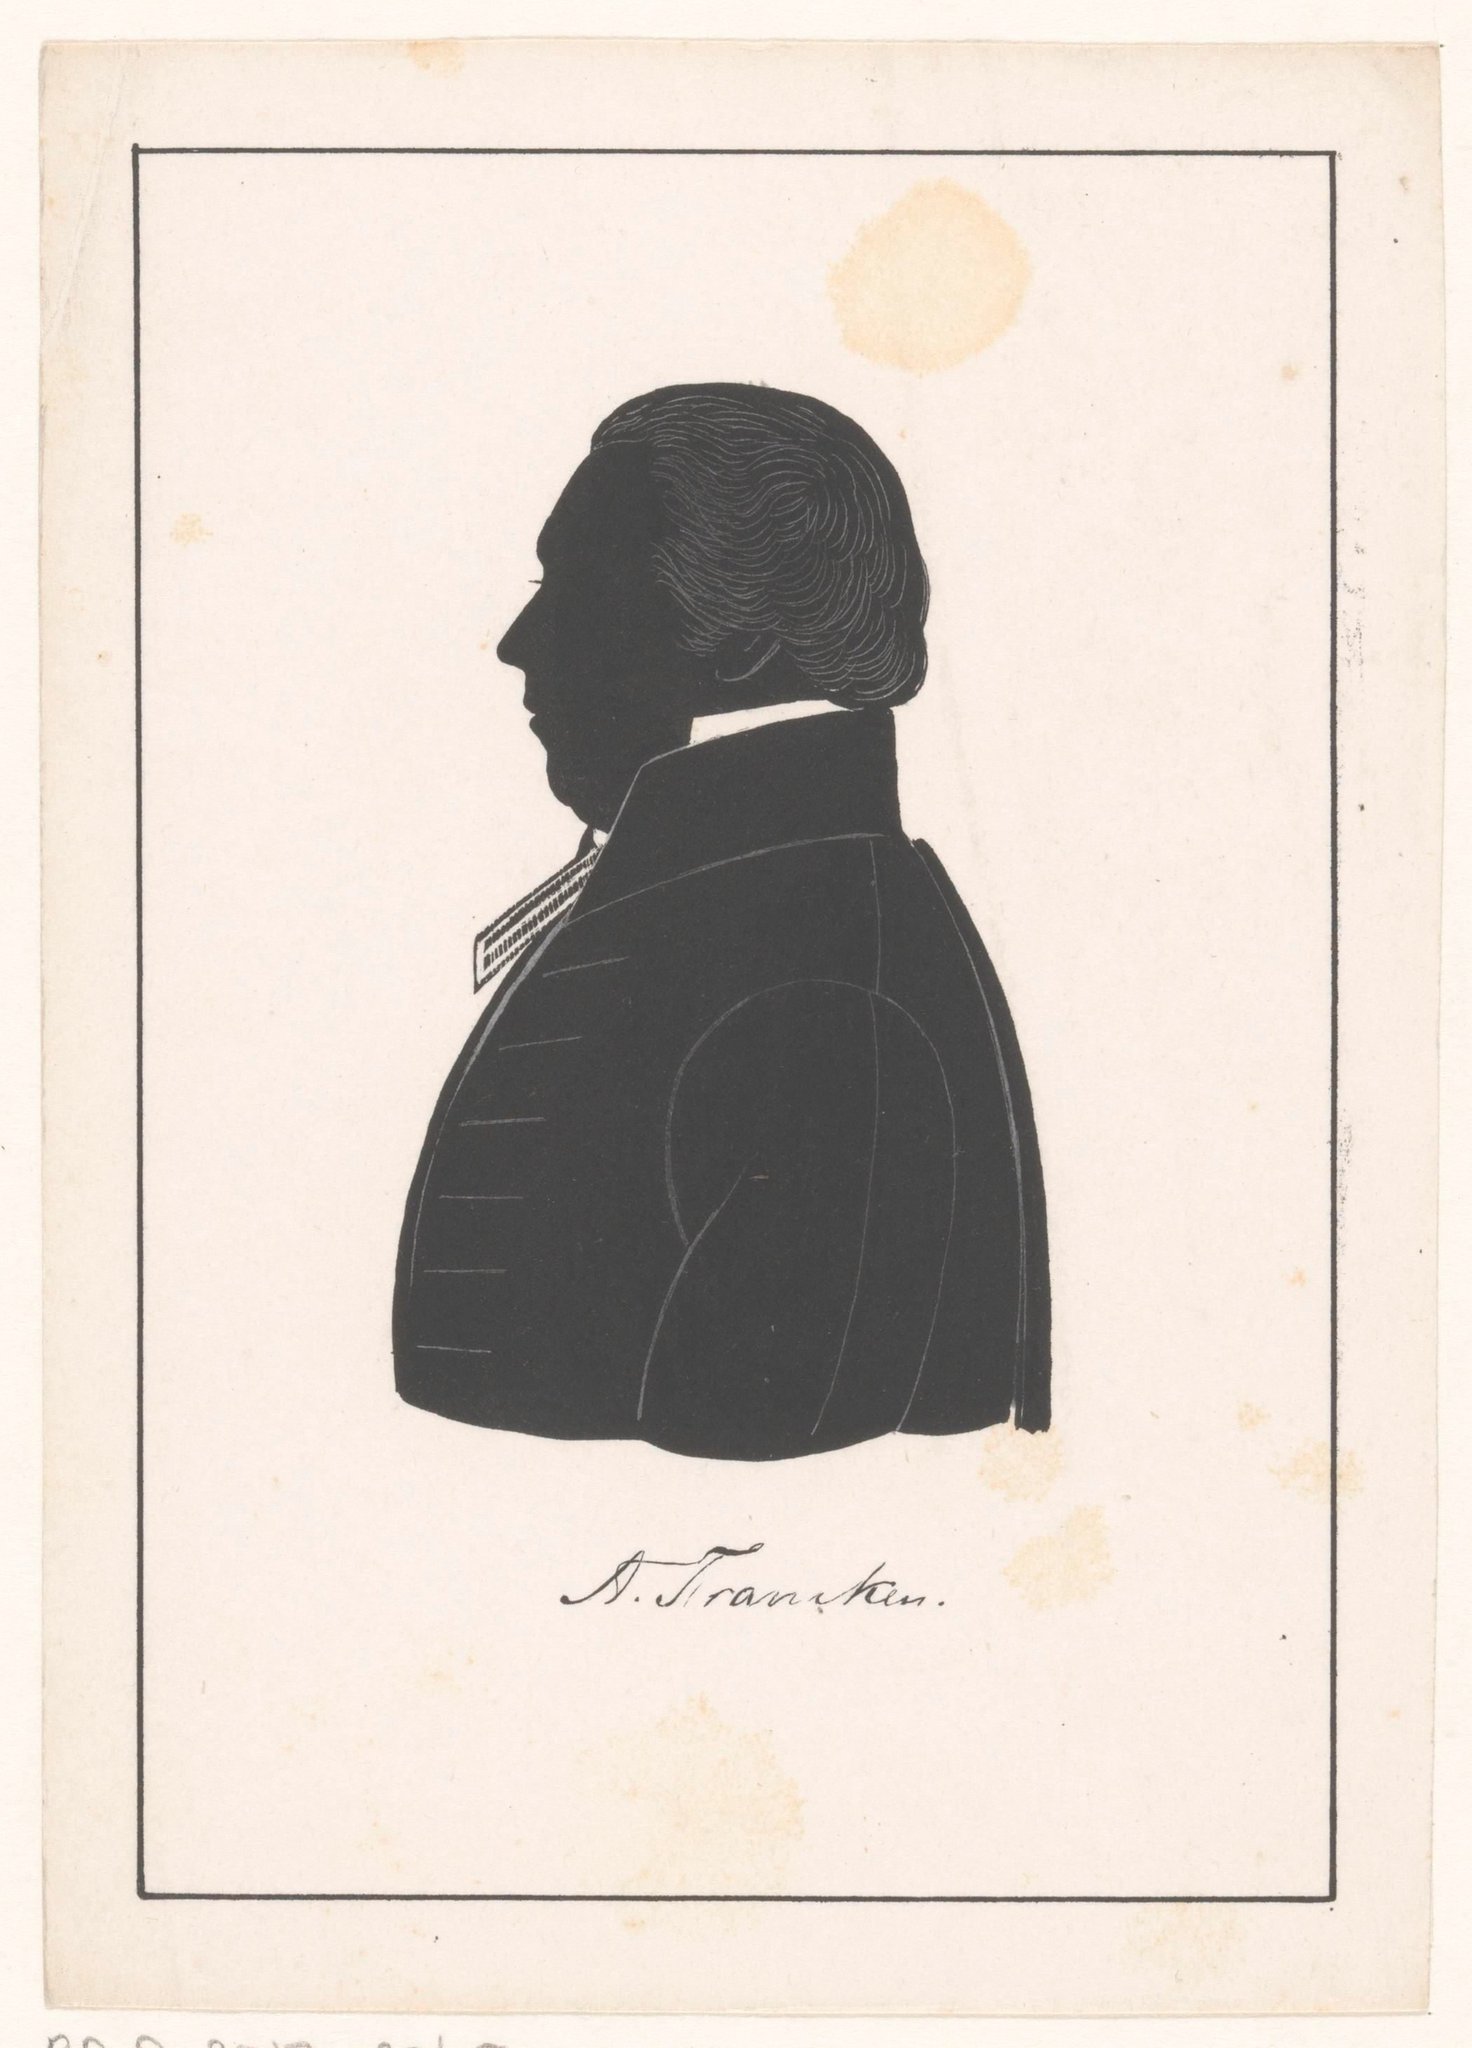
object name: print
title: Silhouetportret van Ahasueros Francken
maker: pieter barbiers (iv)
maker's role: painter, print maker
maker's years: 1798-1848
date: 1809-1848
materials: paper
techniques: hand coloring, lithograph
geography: netherlands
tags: nijmegen, historical persons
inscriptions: collector's mark: Lugt 2228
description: Onder het portret de signatuur van de geportretteerde.